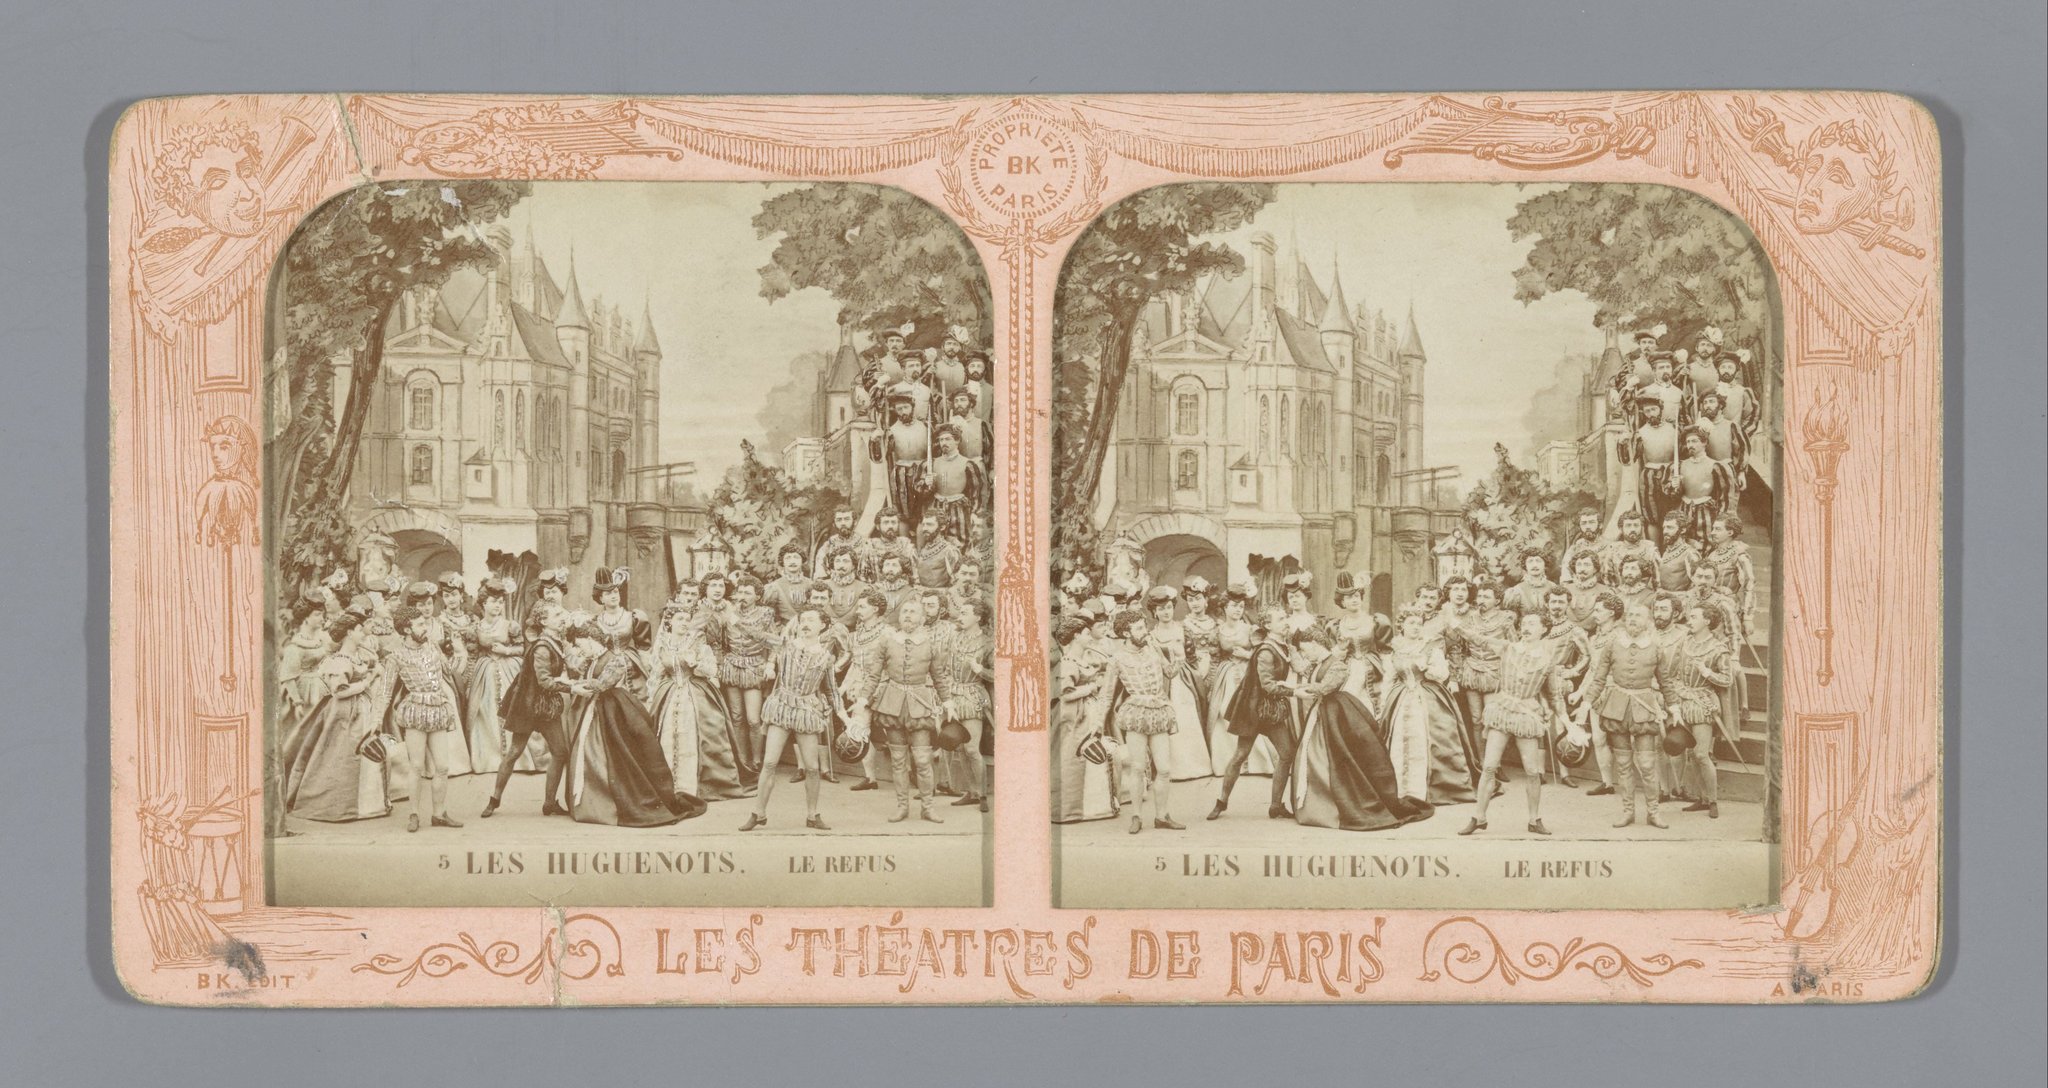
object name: tissue stereograph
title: Scène uit het tweede bedrijf van Les Huguenots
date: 1873-1874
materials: cardboard, paper, photographic support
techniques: albumen print, cutting, hand coloring, perforating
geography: paris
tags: opera, france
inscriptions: number: ‘5’, inscription: ‘PROPRIETE/ BK/ PARIS’